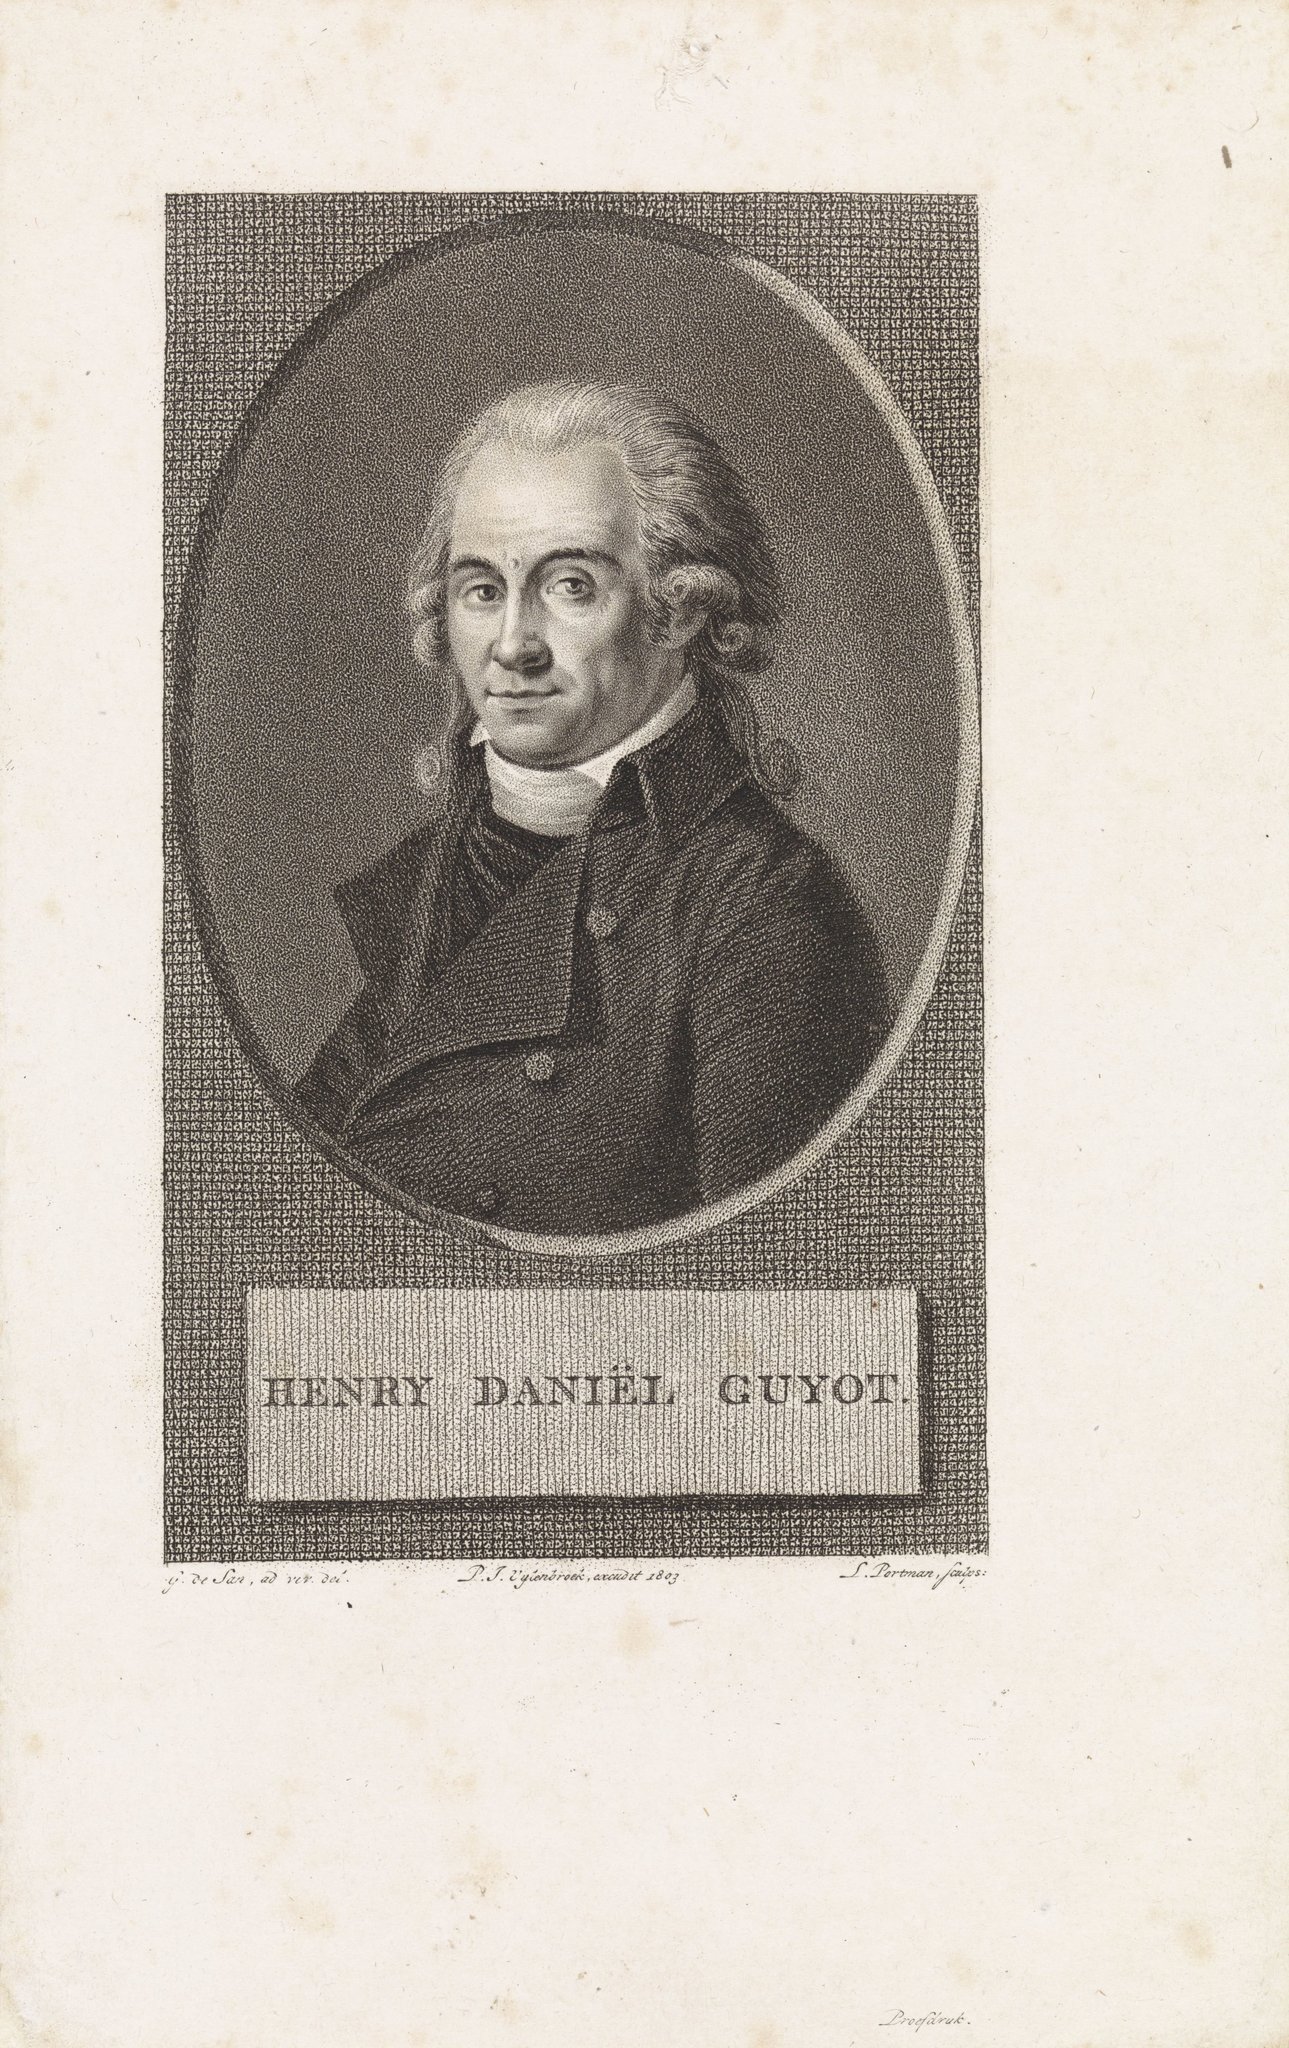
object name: print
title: Portret van de Waalse predikant Henri Daniël Guyot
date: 1803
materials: paper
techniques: stippled etching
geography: amsterdam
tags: henri daniël guyot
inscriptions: collector's mark: Lugt 2228